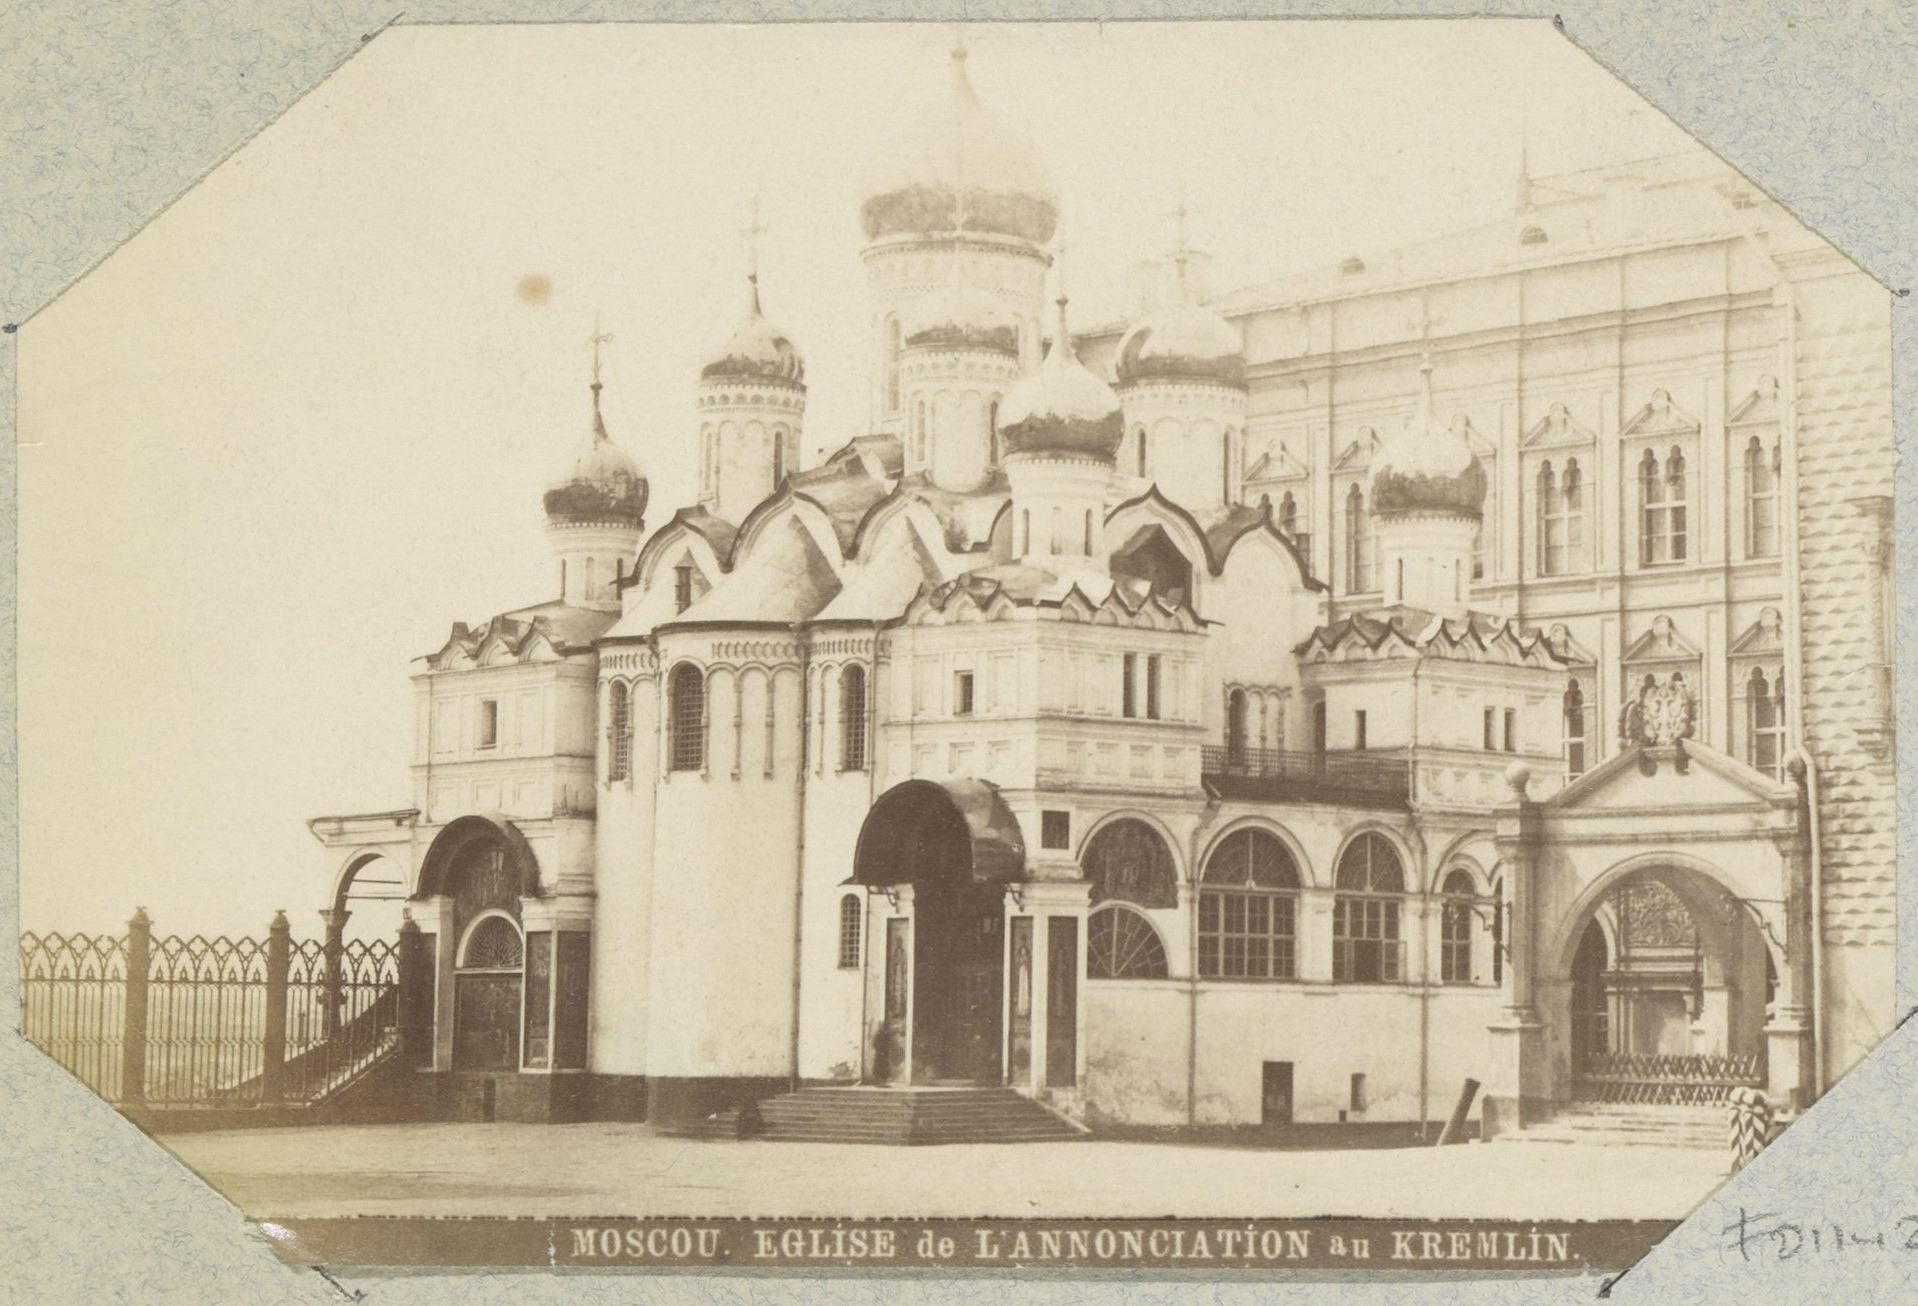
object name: album leaf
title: Exterieur van de Verkondigingskathedraal in Moskou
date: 1890-1900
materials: paper, photographic support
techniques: albumen print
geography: moscow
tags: russian orthodox church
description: Onderdeel van Album van een Franse amateur met foto's van Frankrijk, Algerije, Palmyra, de Wereldtentoonstelling van 1900 en van bekende Fransen.